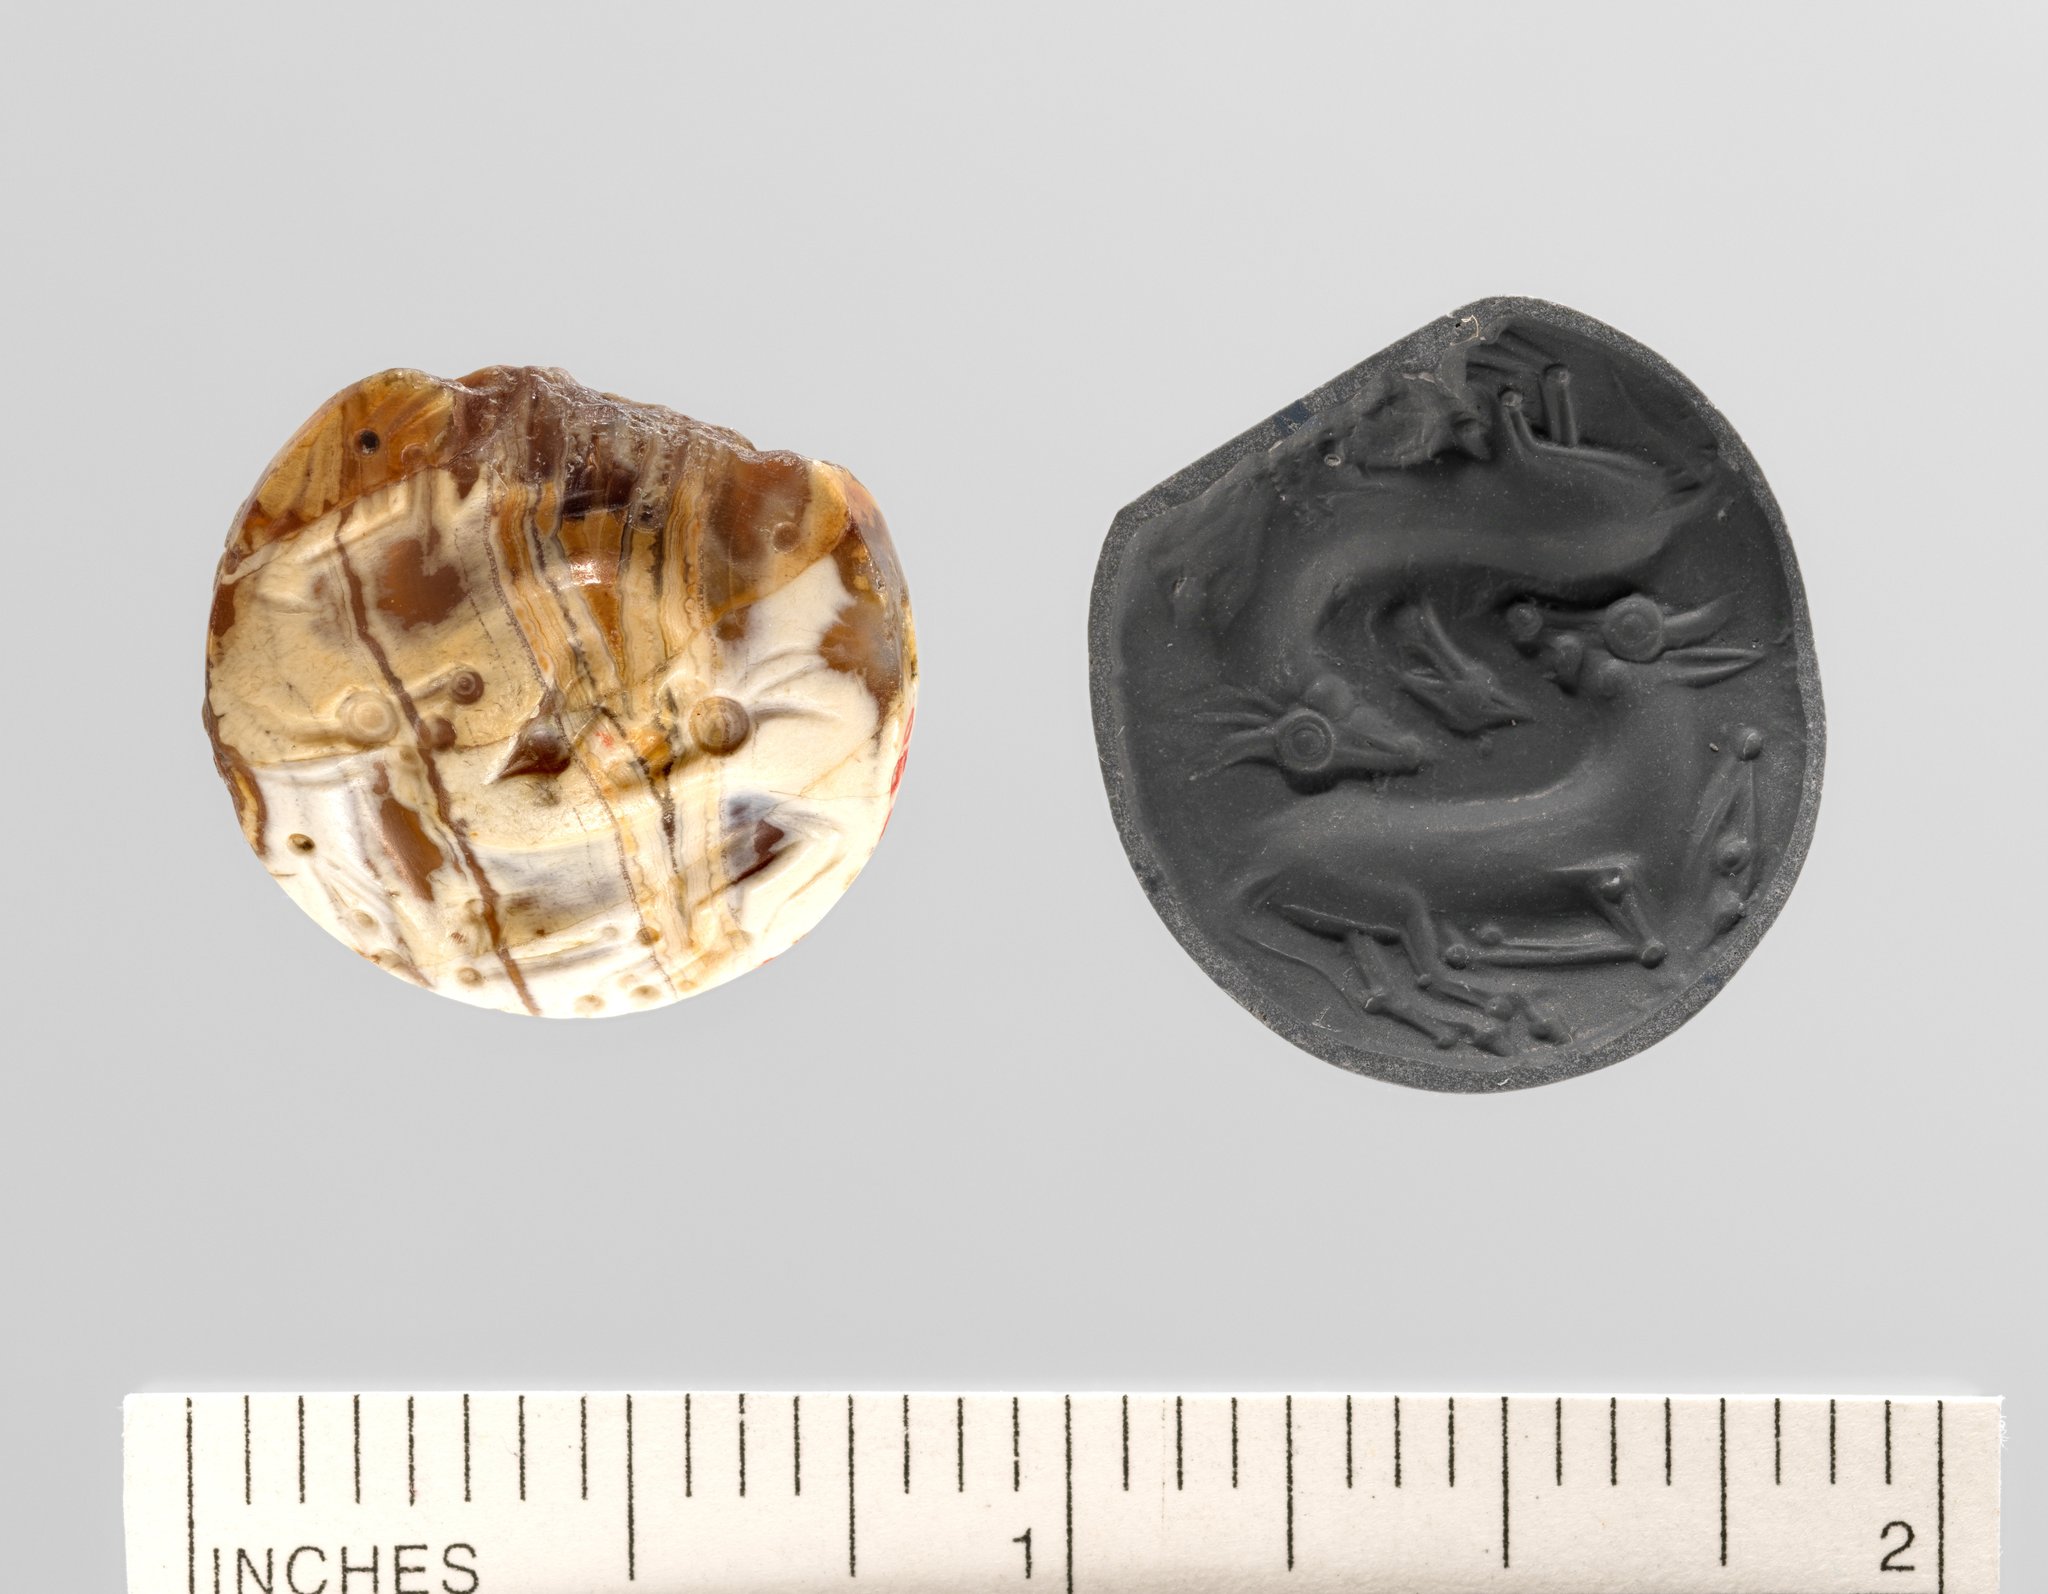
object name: seal, lentoid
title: Agate Lentoid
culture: minoan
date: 1450-1375 BCE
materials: stone